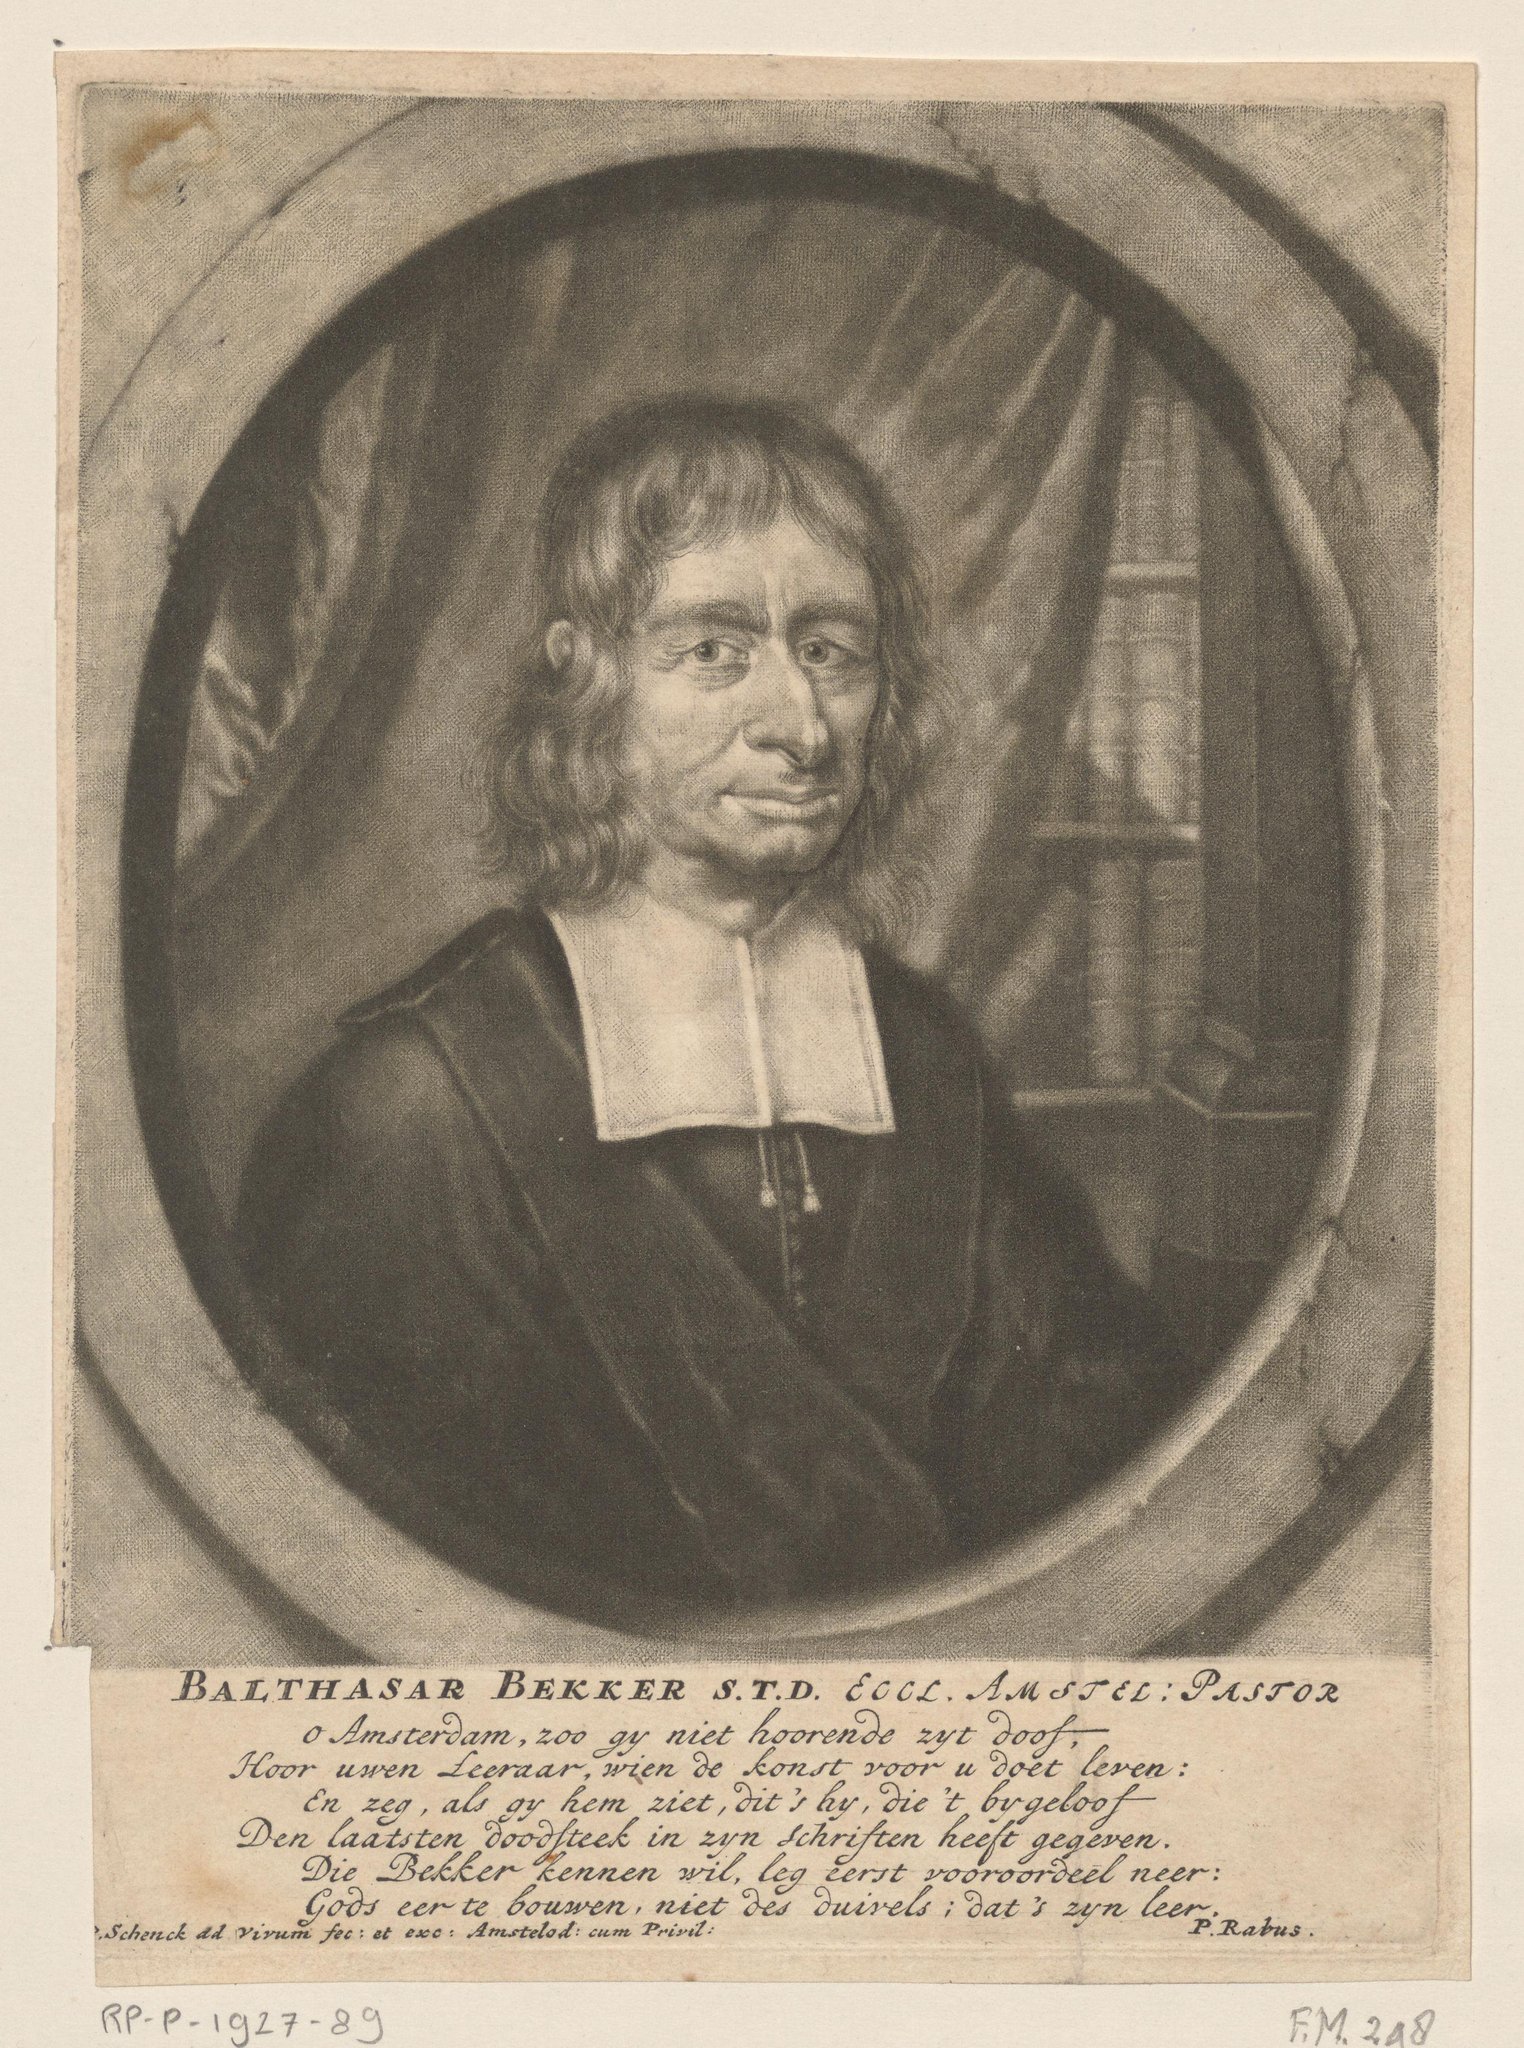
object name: print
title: Portret van Balthasar Bekker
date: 1670-1711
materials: paper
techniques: engraving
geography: amsterdam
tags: amsterdam, balthasar bekker, bookshelves, historical persons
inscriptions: collector's mark: Lugt 2166